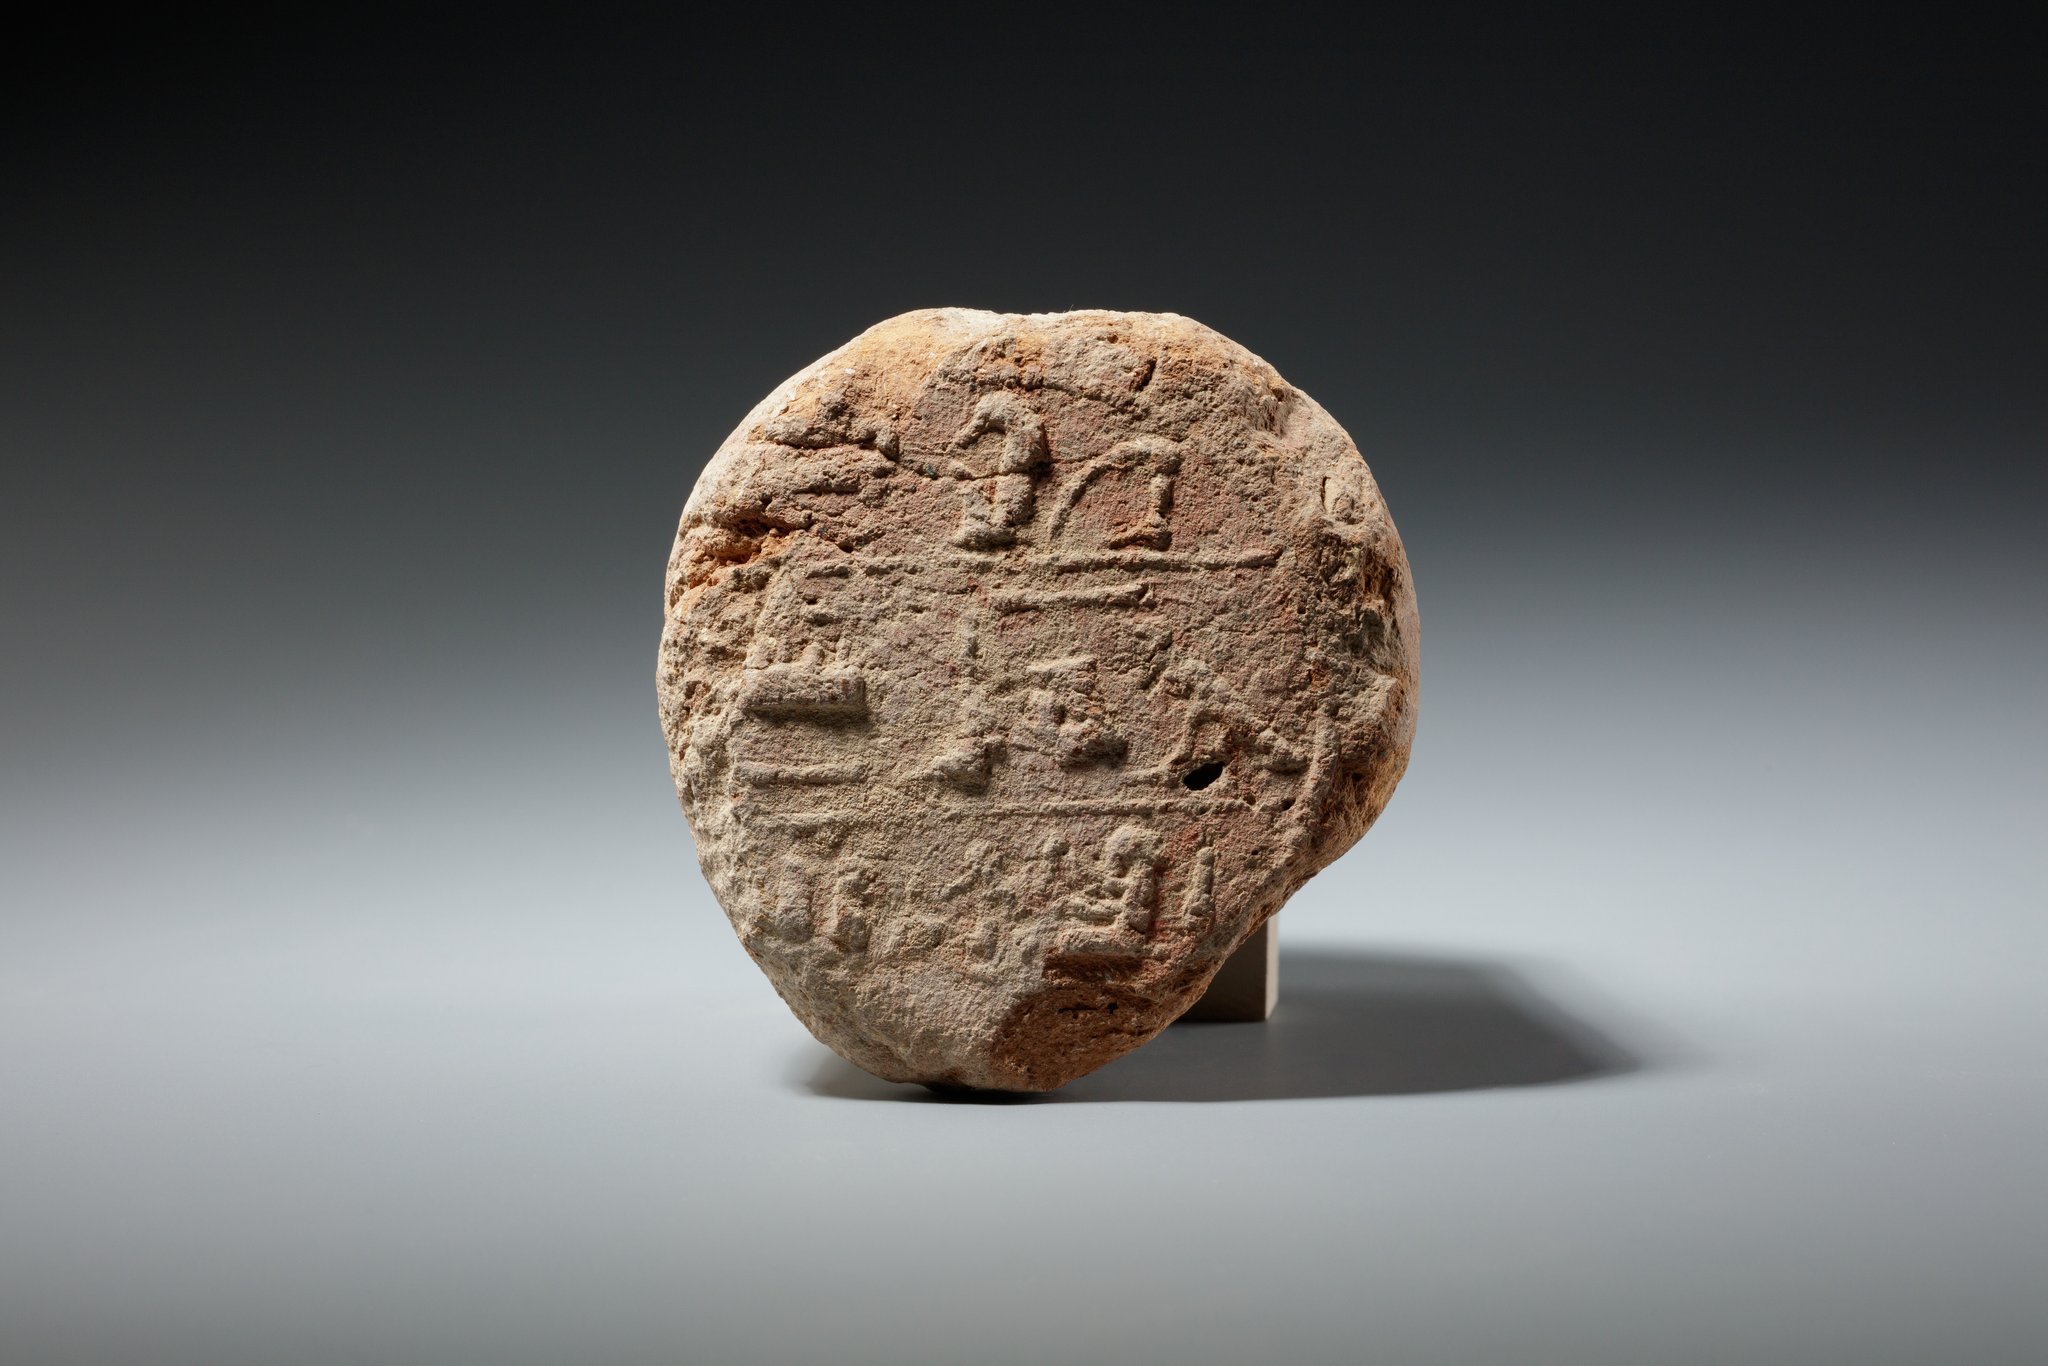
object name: cone, davy 528, bengy, wab priest, amun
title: Funerary Cone of the Wab-Preist Bengy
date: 1550-1295 BCE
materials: pottery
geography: egypt